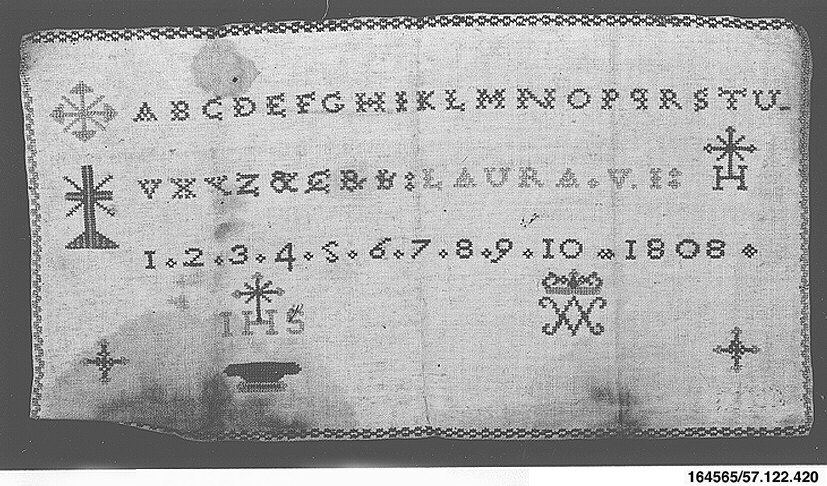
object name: sampler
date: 1808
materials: linen, silk